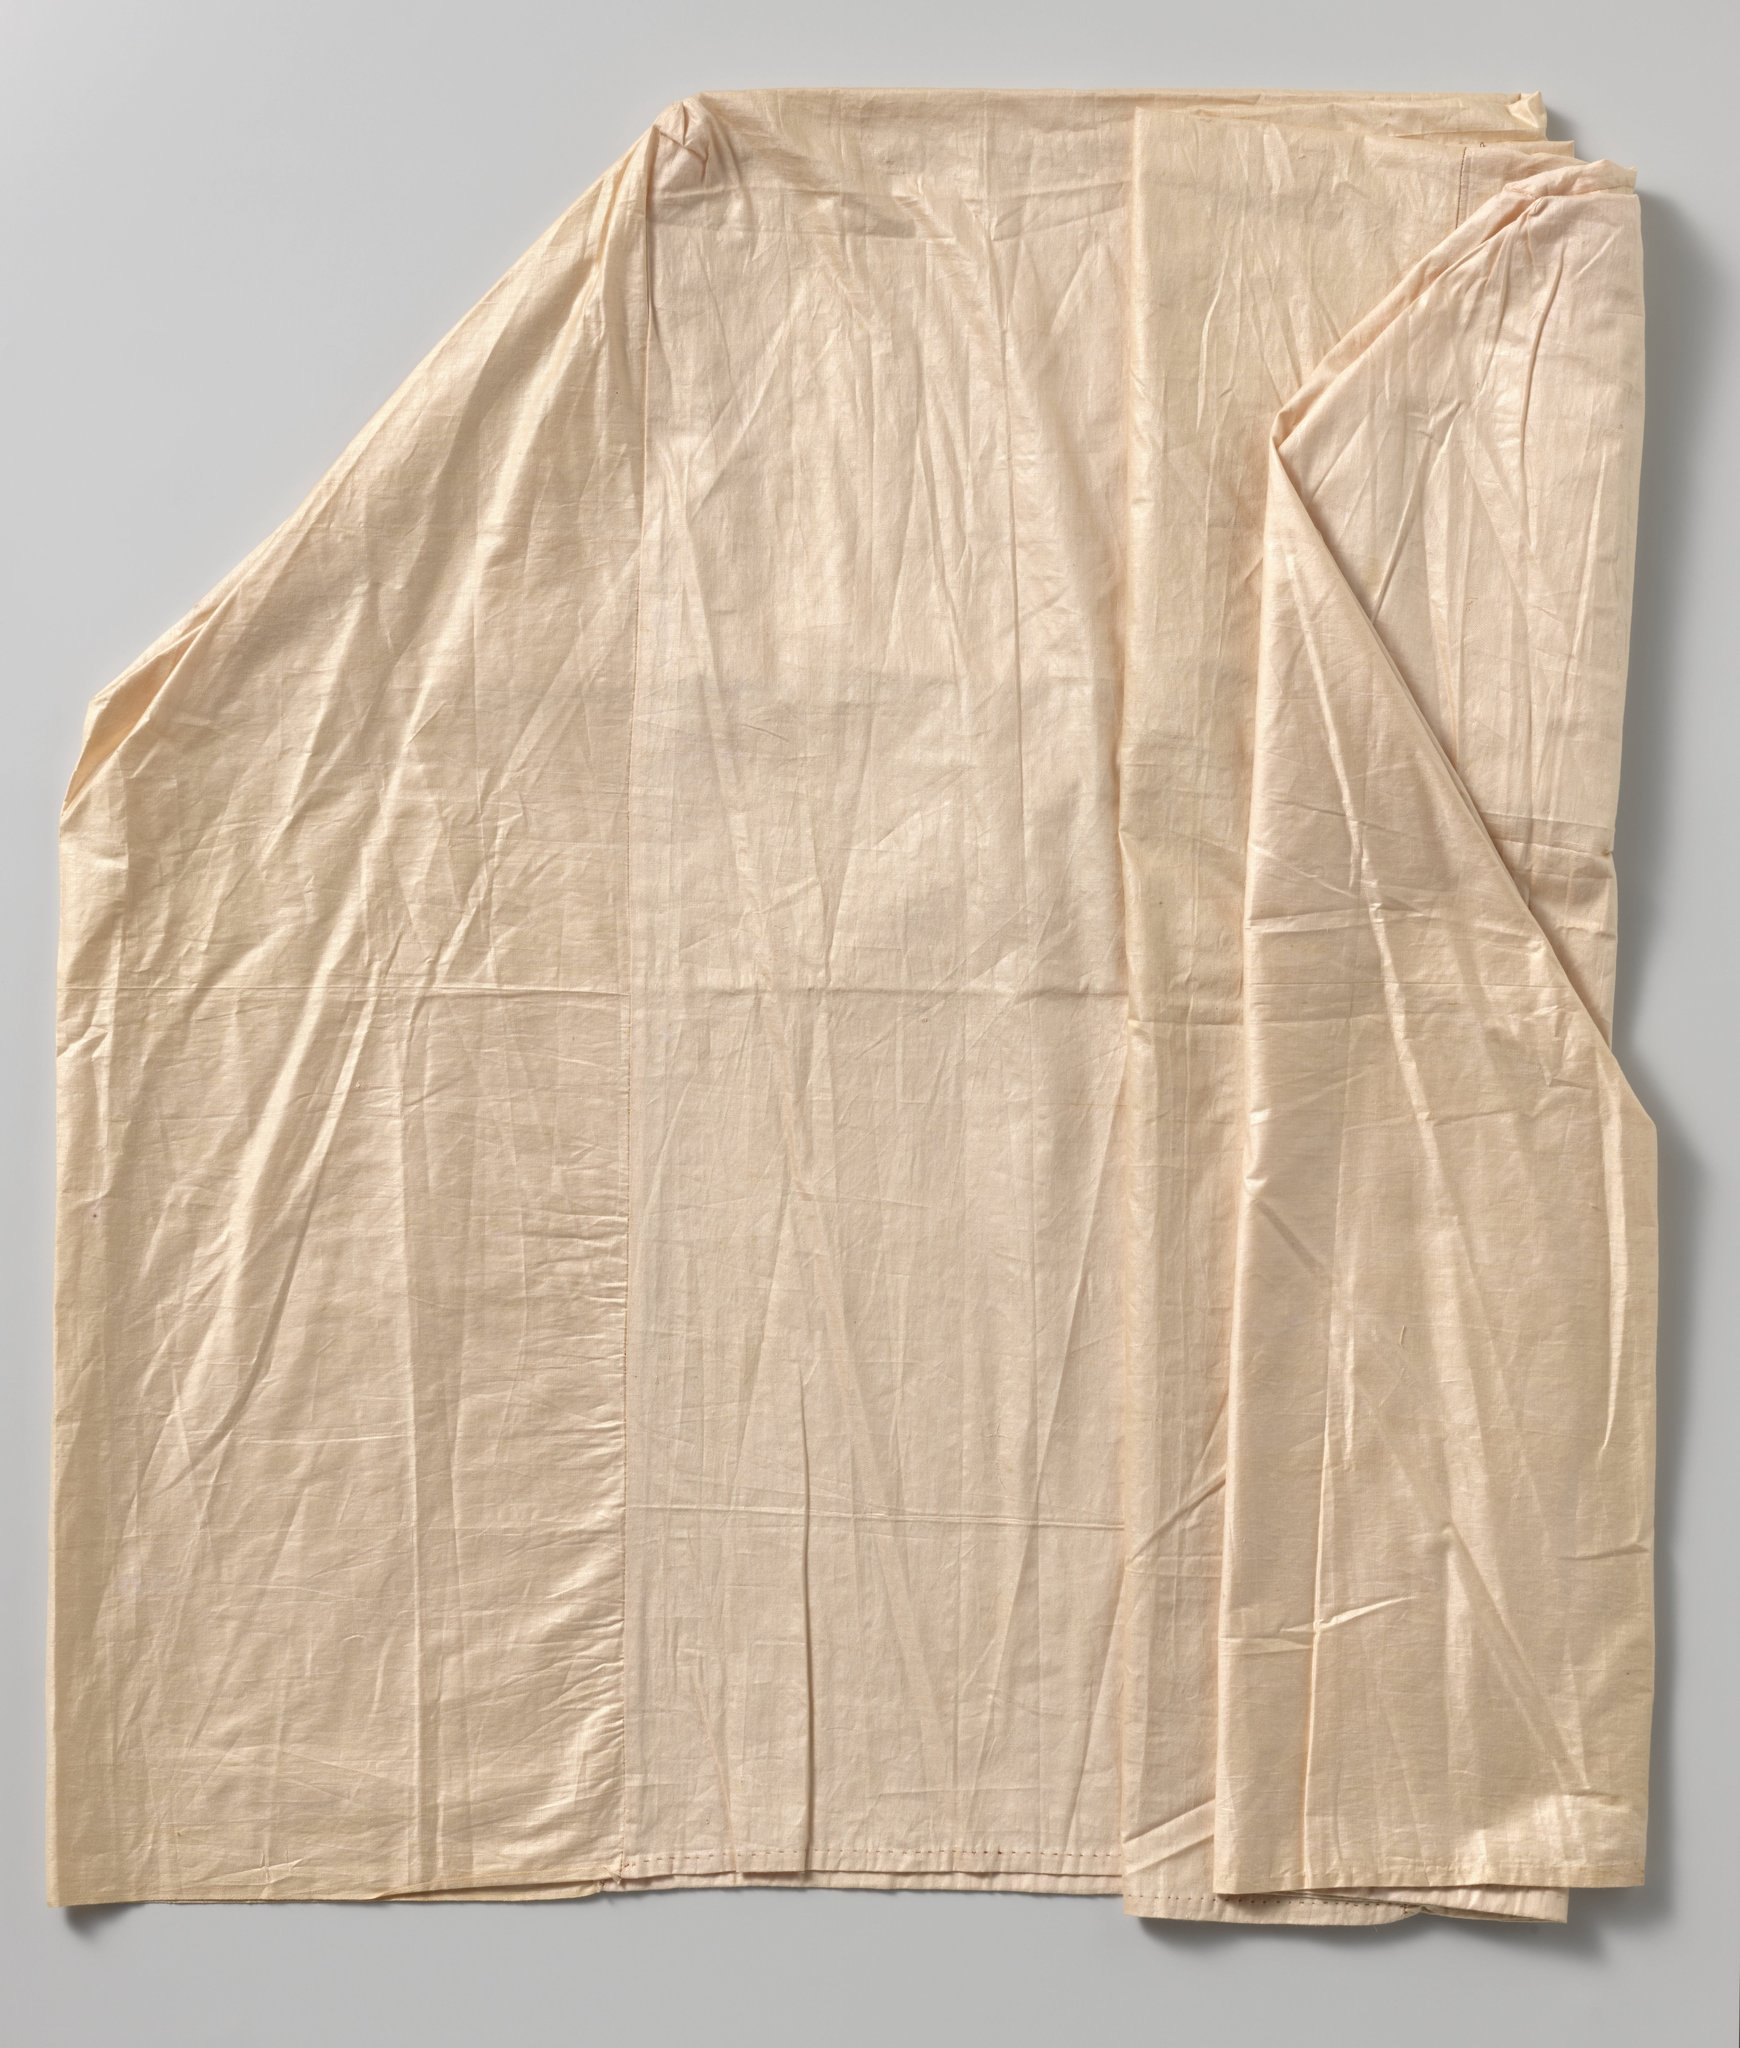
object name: covering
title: Tafelovertrek of hoes van roze katoen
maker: Anonymous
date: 1820-1870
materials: cotton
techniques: weave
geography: france